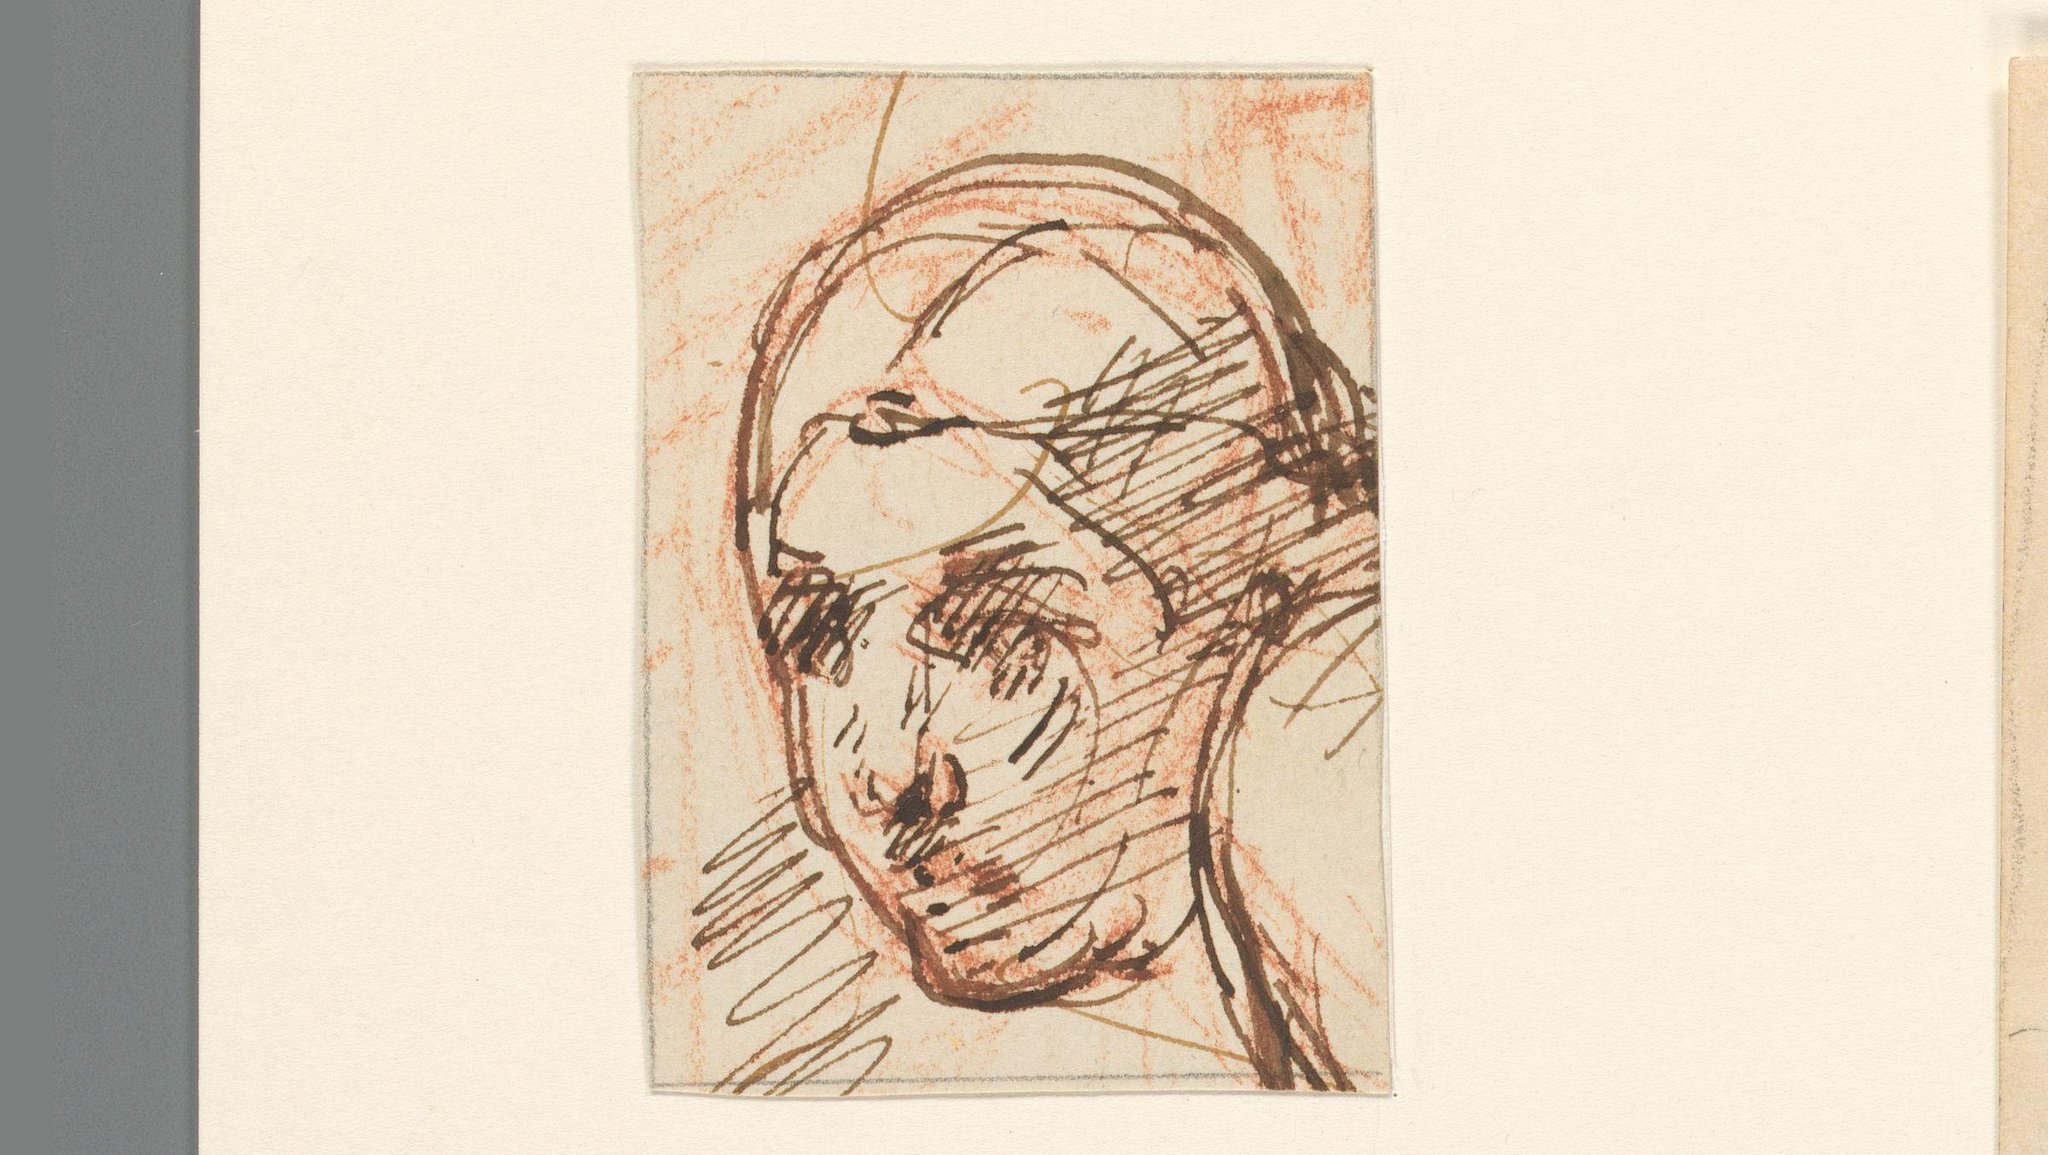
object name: drawing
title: Schetsblad met kopstudie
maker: august allebé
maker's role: draughtsman, print maker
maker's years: 1838-1927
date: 1848-1927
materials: chalk, ink, paper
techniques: pen